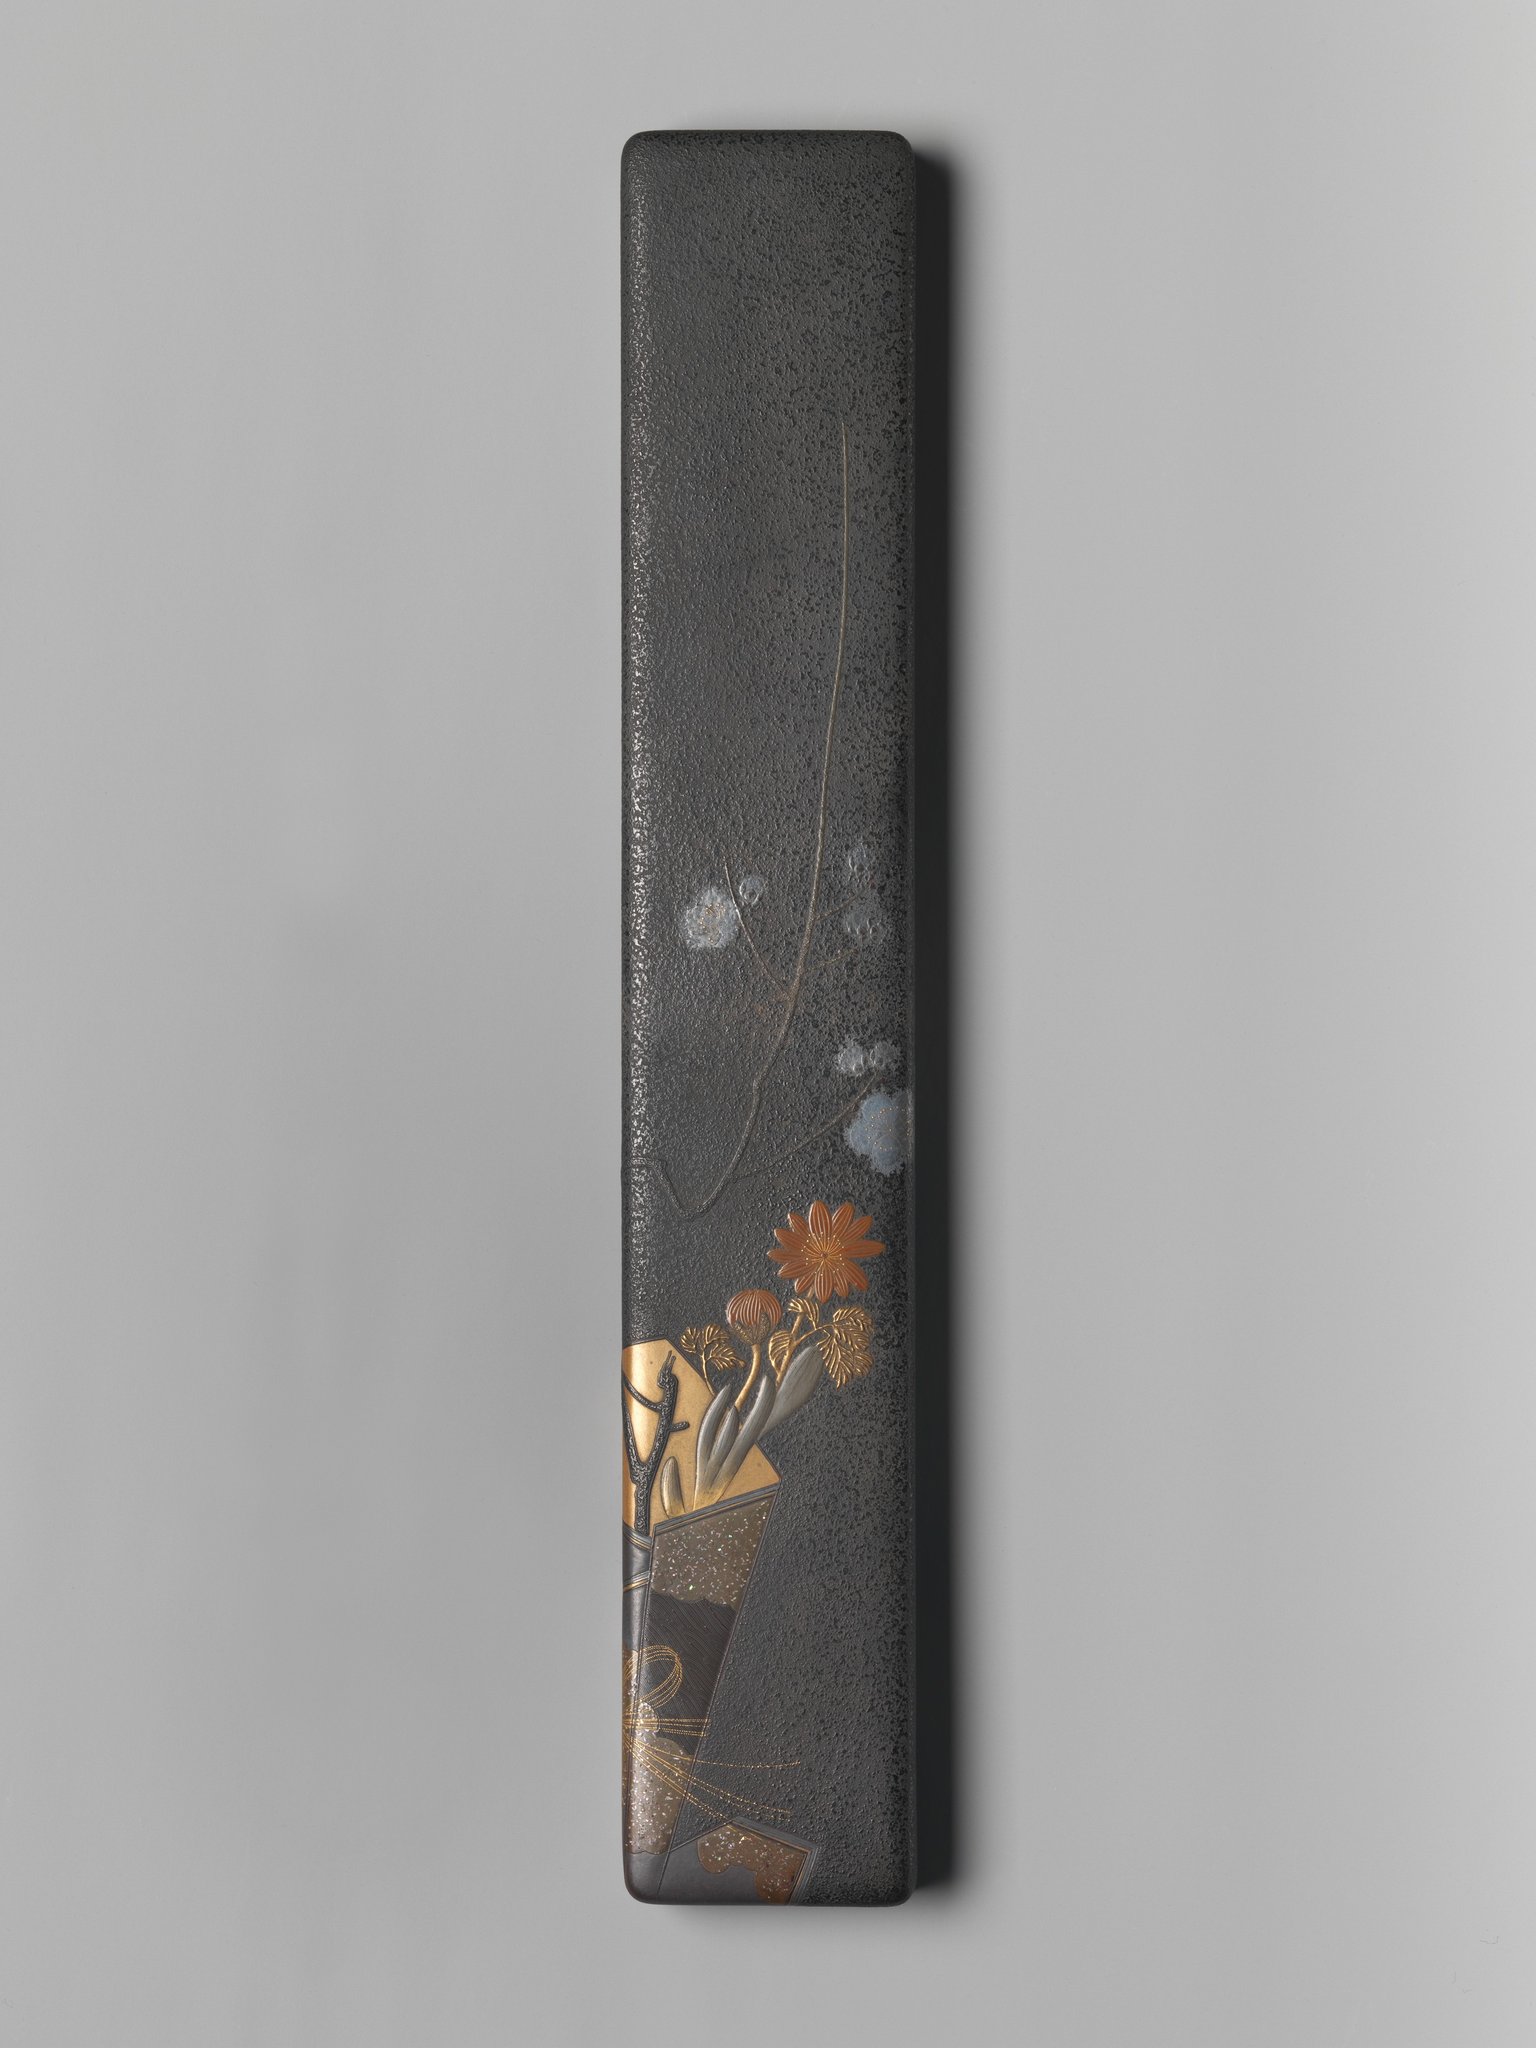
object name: box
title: Poem Card (Tanzaku) Box with Flower Bouquet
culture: japanese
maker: shibata zeshin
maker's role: artist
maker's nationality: japanese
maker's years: 1807-1891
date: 1801-1900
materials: gold, silver, wood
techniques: hiramakie, lacquer, maki-e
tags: flowers